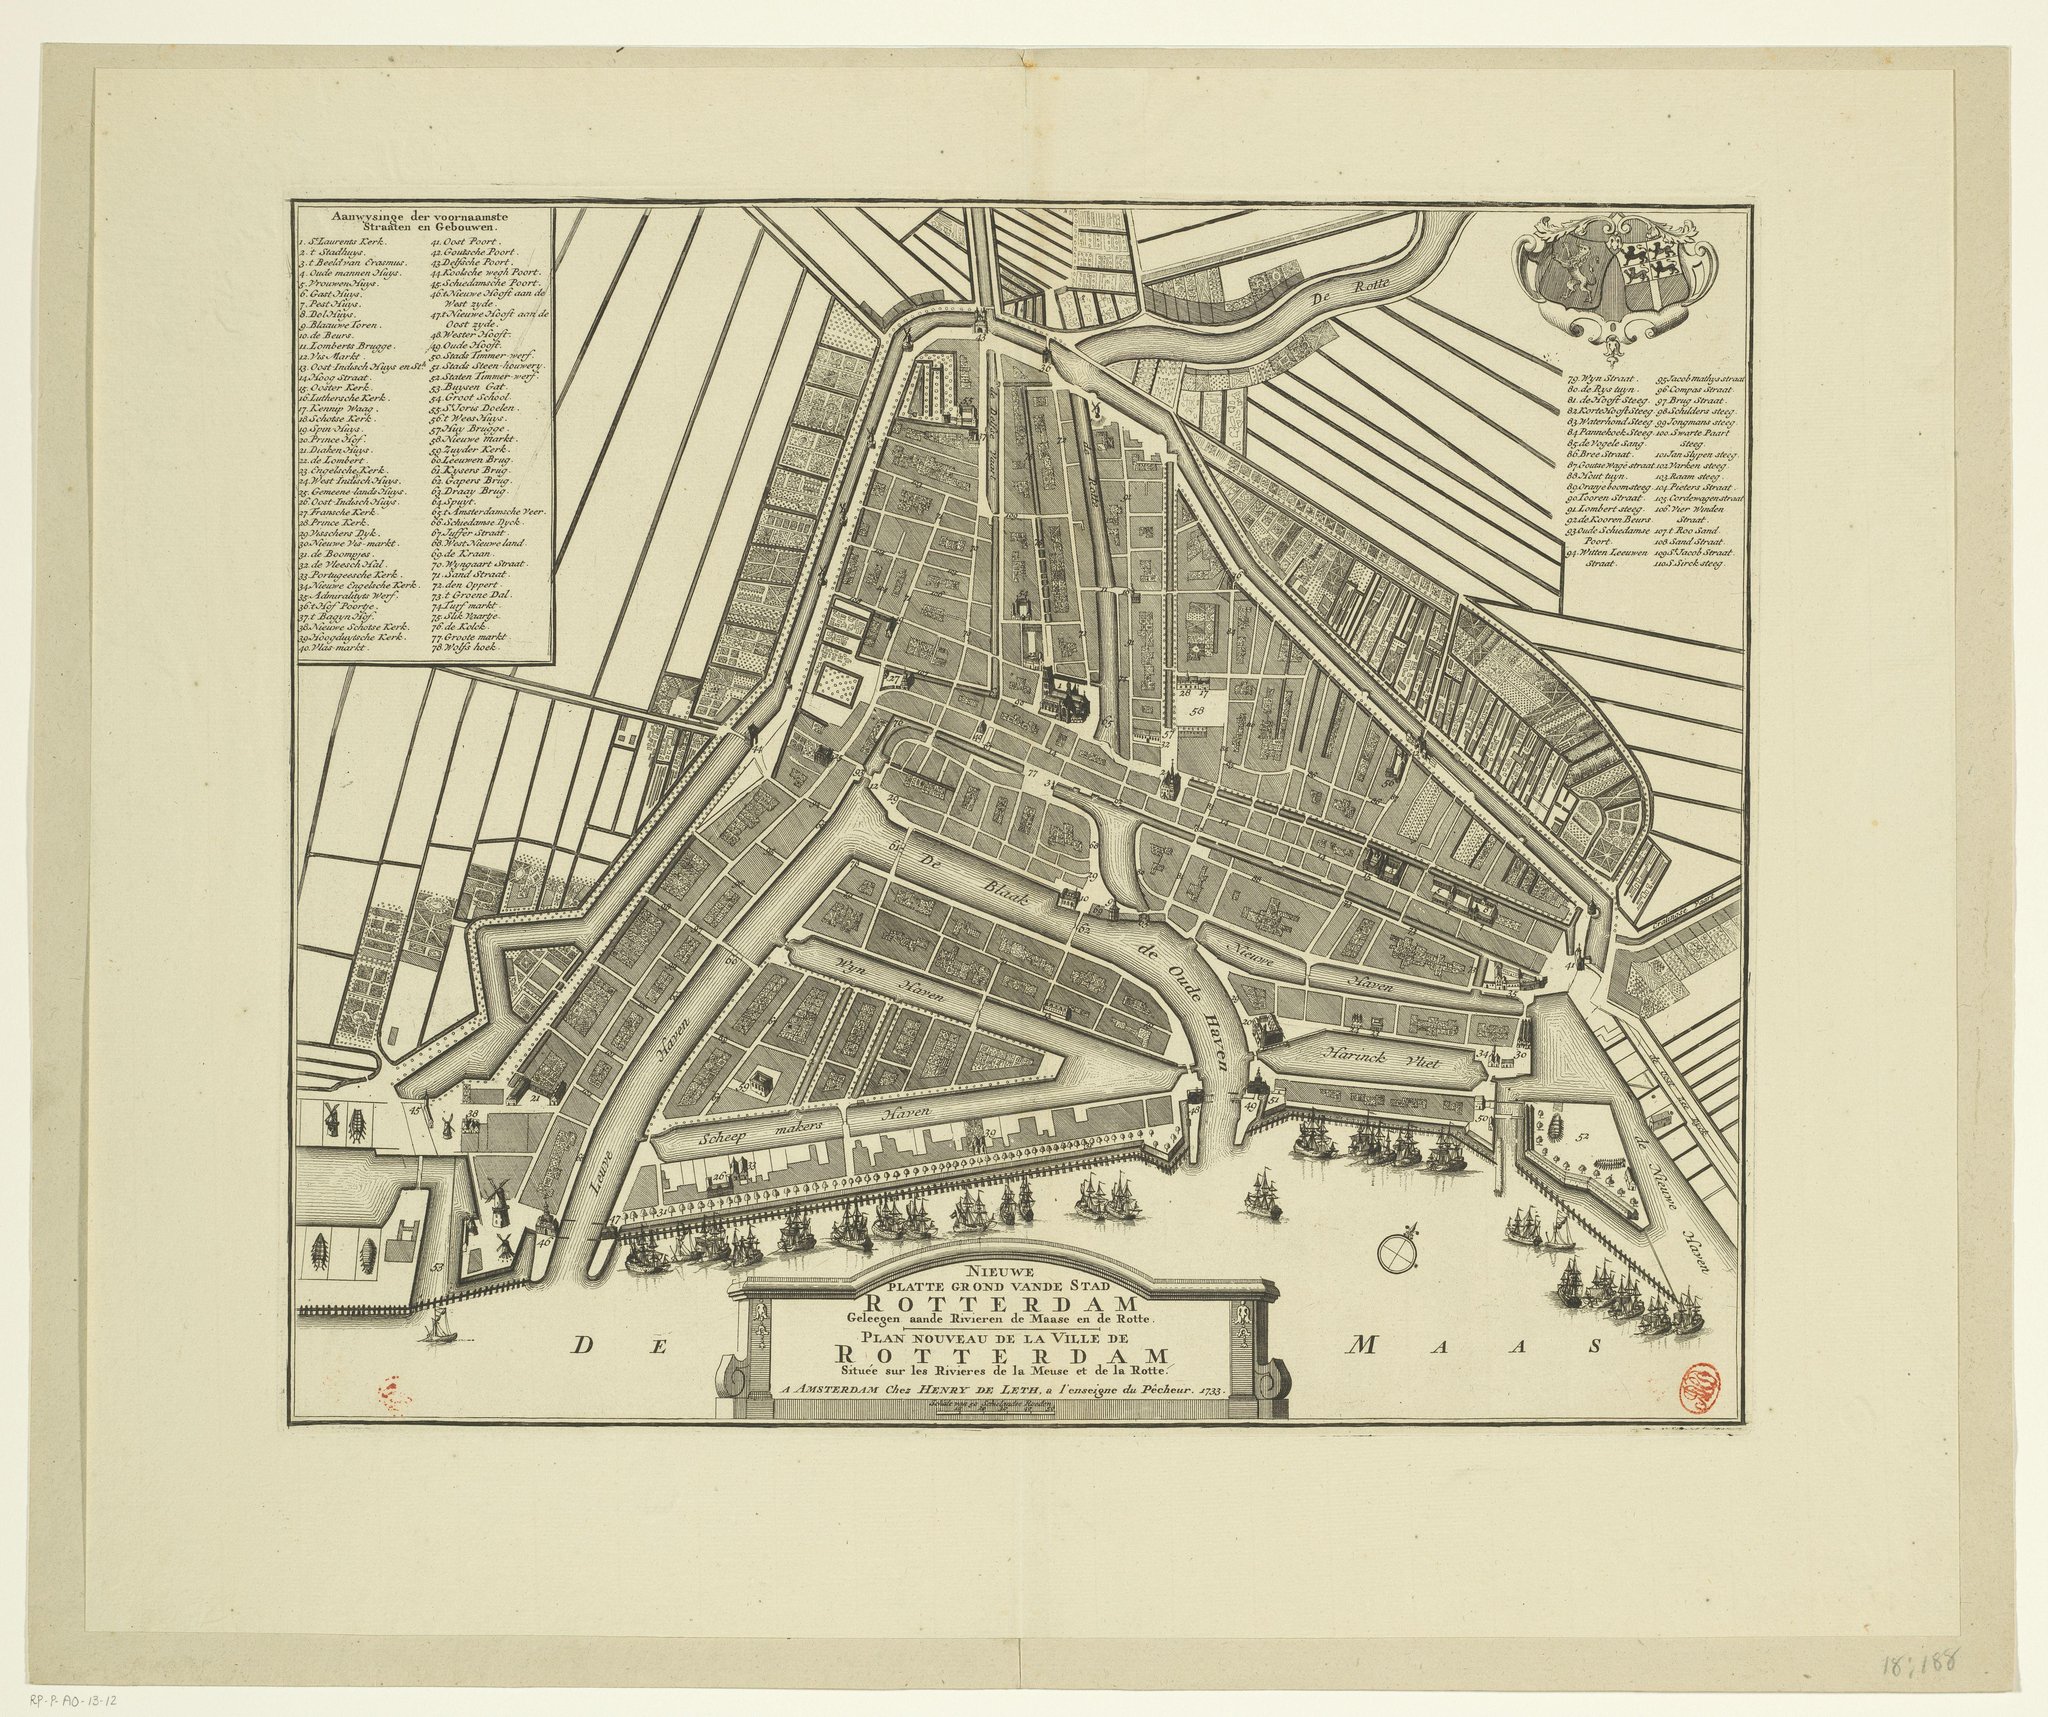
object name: area plan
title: Plattegrond van Rotterdam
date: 1733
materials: paper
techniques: engraving, etching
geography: amsterdam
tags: coat of arms (as symbol of the state, etc.) (+ city; municipal), maps of cities, coat of arms (as symbol of the state, etc.) (+ province; provincial), rotterdam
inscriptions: collector's mark: Lugt 2228, collector's mark: Lugt 195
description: Plattegrond met gebouwen in vogelvluchtperspectief. Linksboven een cartouche met de legenda 1-78. Rechtsboven een cartouche met de wapens van Holland en van Rotterdam, daaronder de legenda 79-110. Onder in het midden een cartouche met de titel en de schaalstok: Schale van 50 Schielandse roeden.